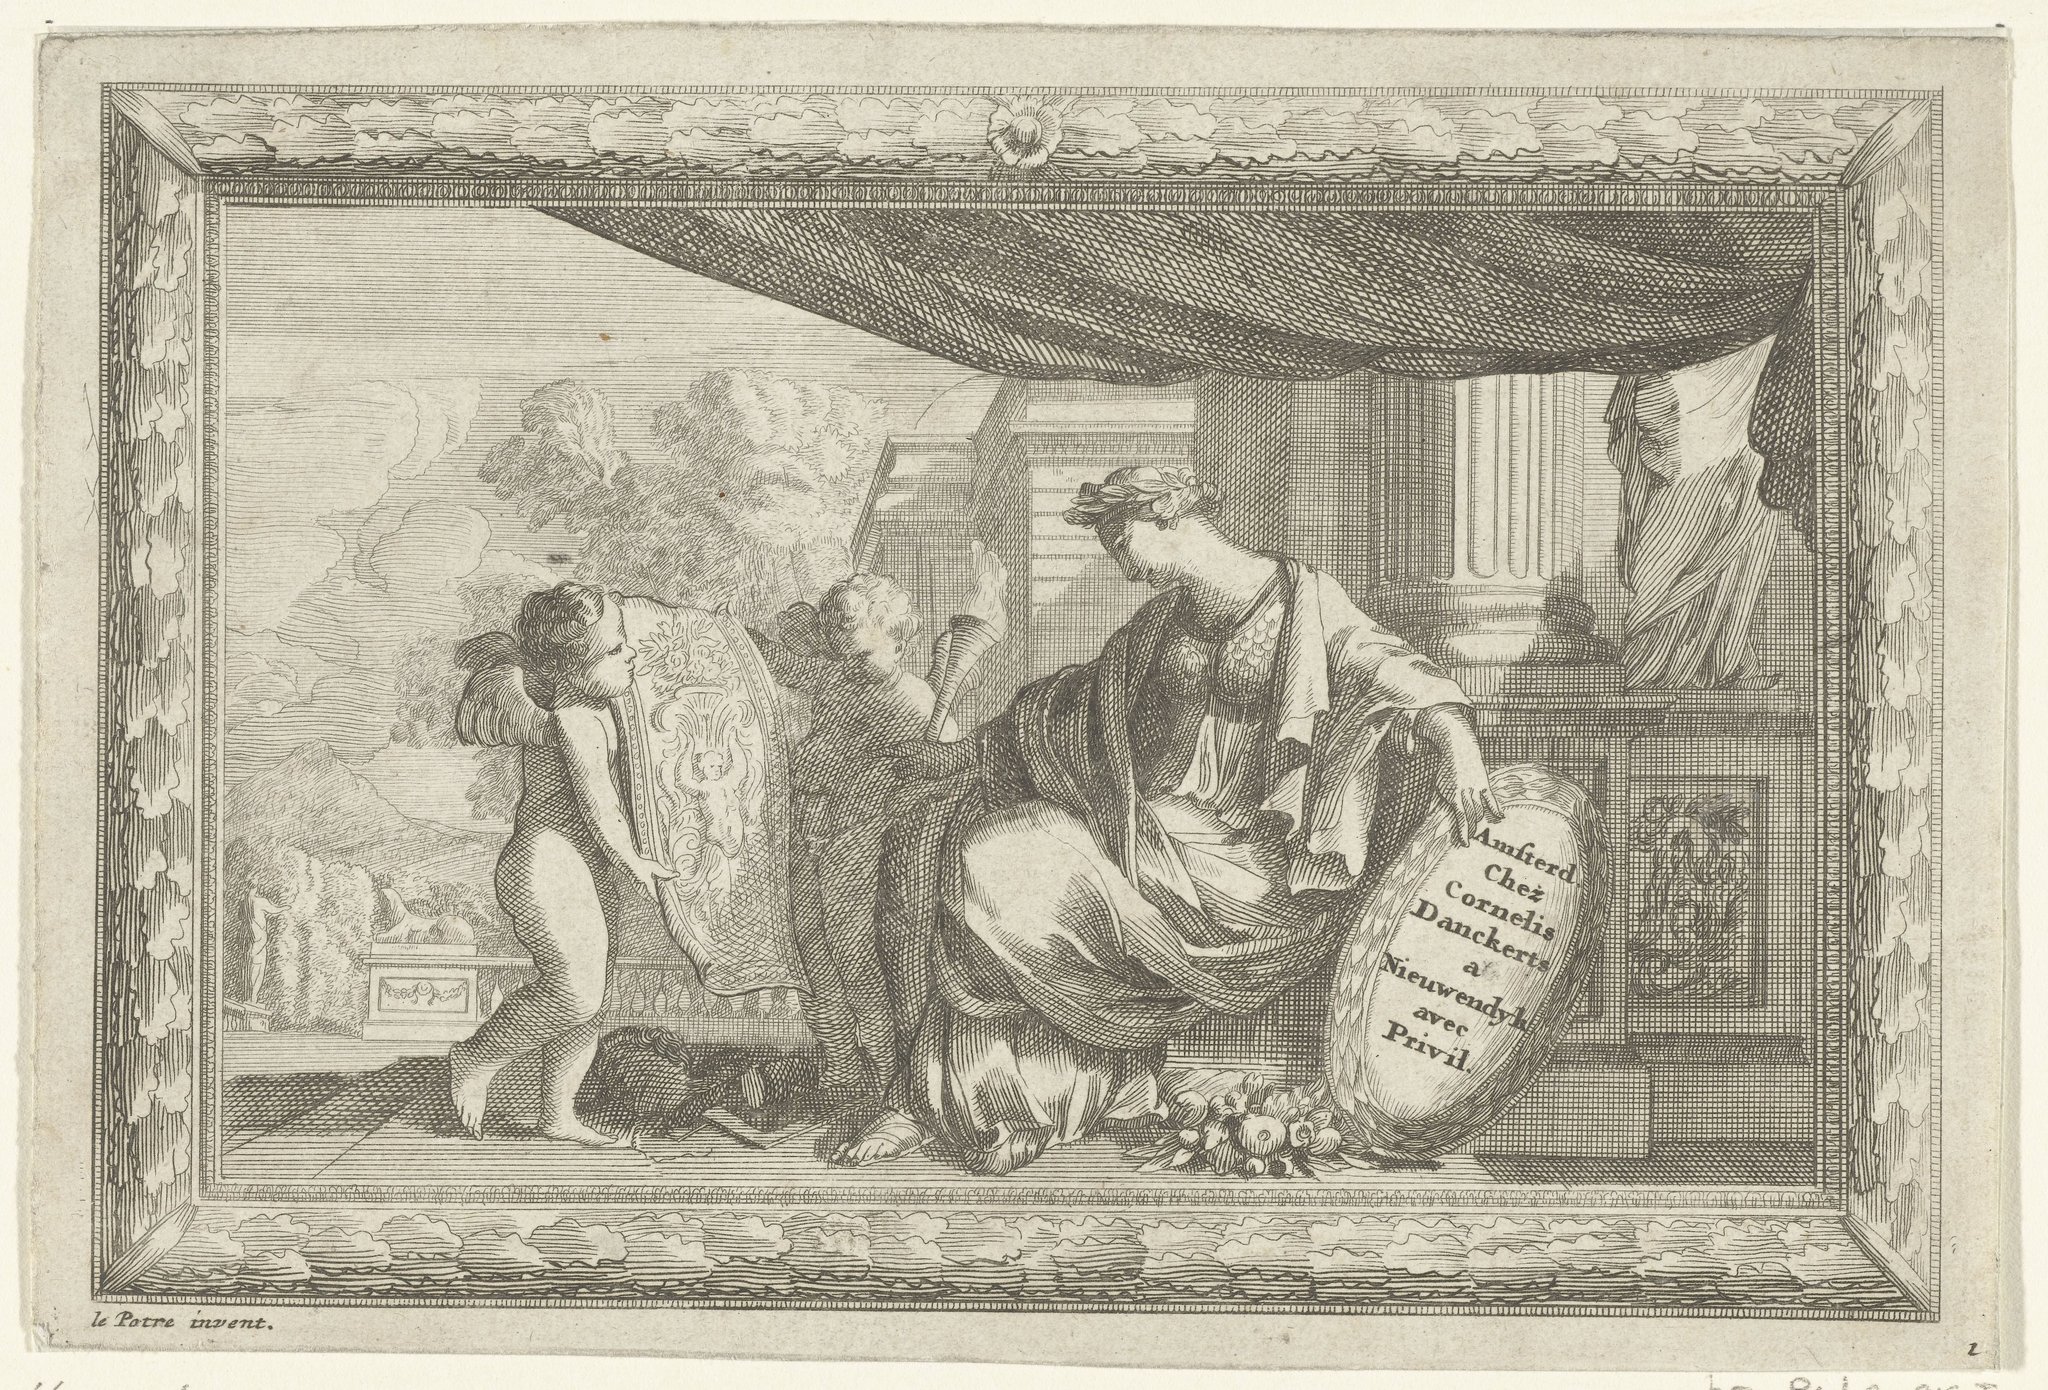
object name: ornament print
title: Ornamentele panelen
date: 1696-1717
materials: paper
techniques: etching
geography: netherlands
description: Landschap met gebouwen op de achtergrond, twee putti laten een wandtapijt aan Minerva zien die een wapenschild met het adres vasthoudt.